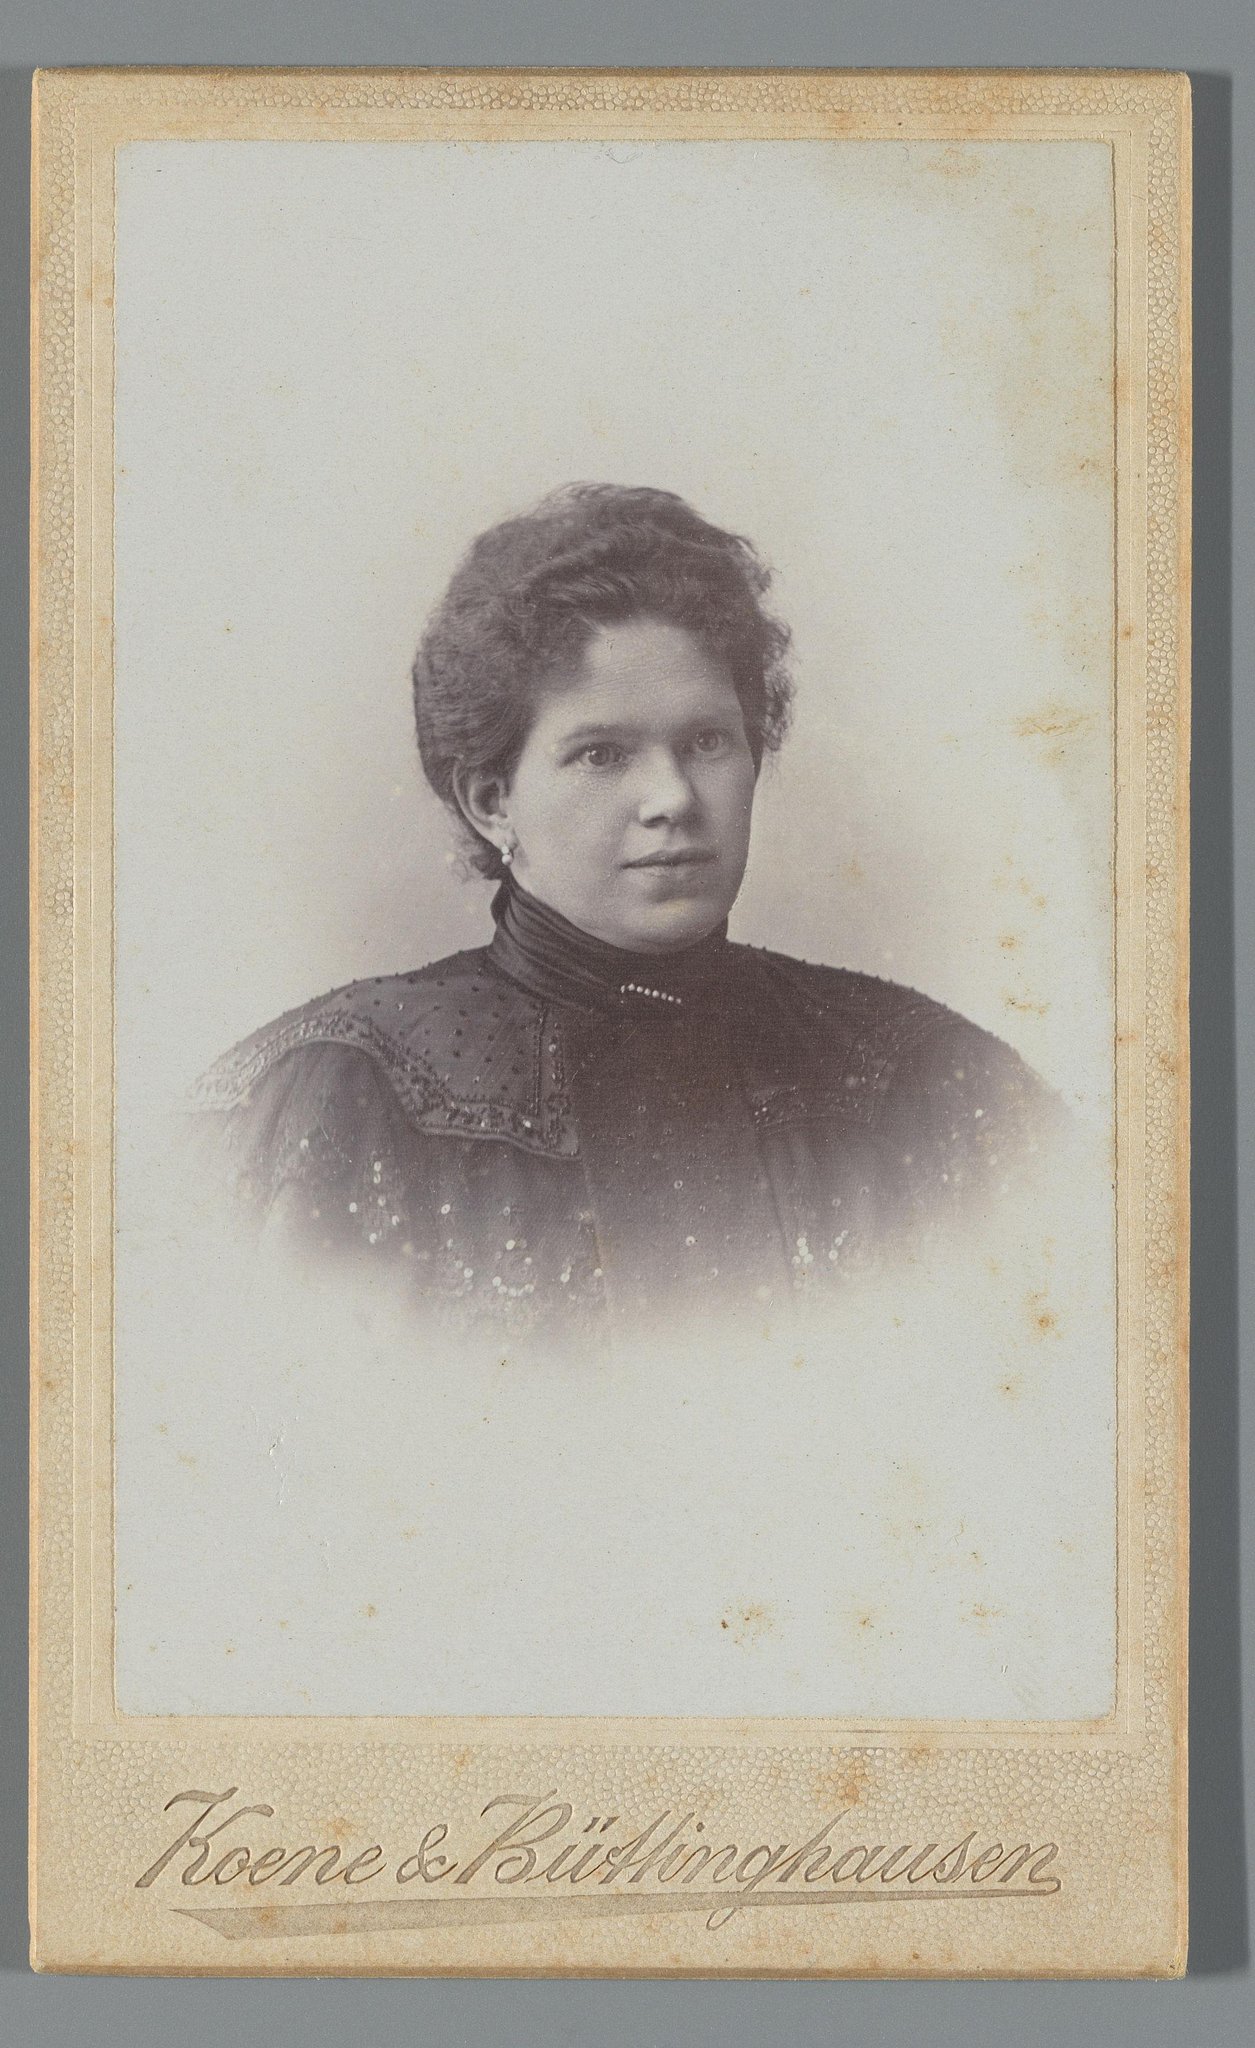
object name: photograph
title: Studioportret van Emilie van den Berg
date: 1860-1910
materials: cardboard, photographic support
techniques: albumen print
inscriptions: name: ‘Koene & Büttinghausen / AMSTERDAM / Heerengracht 150. / BATAVIA.’, name: ‘Koene & Büttinghausen’, inscription: ‘E . A. Onnen - / van den Berg’